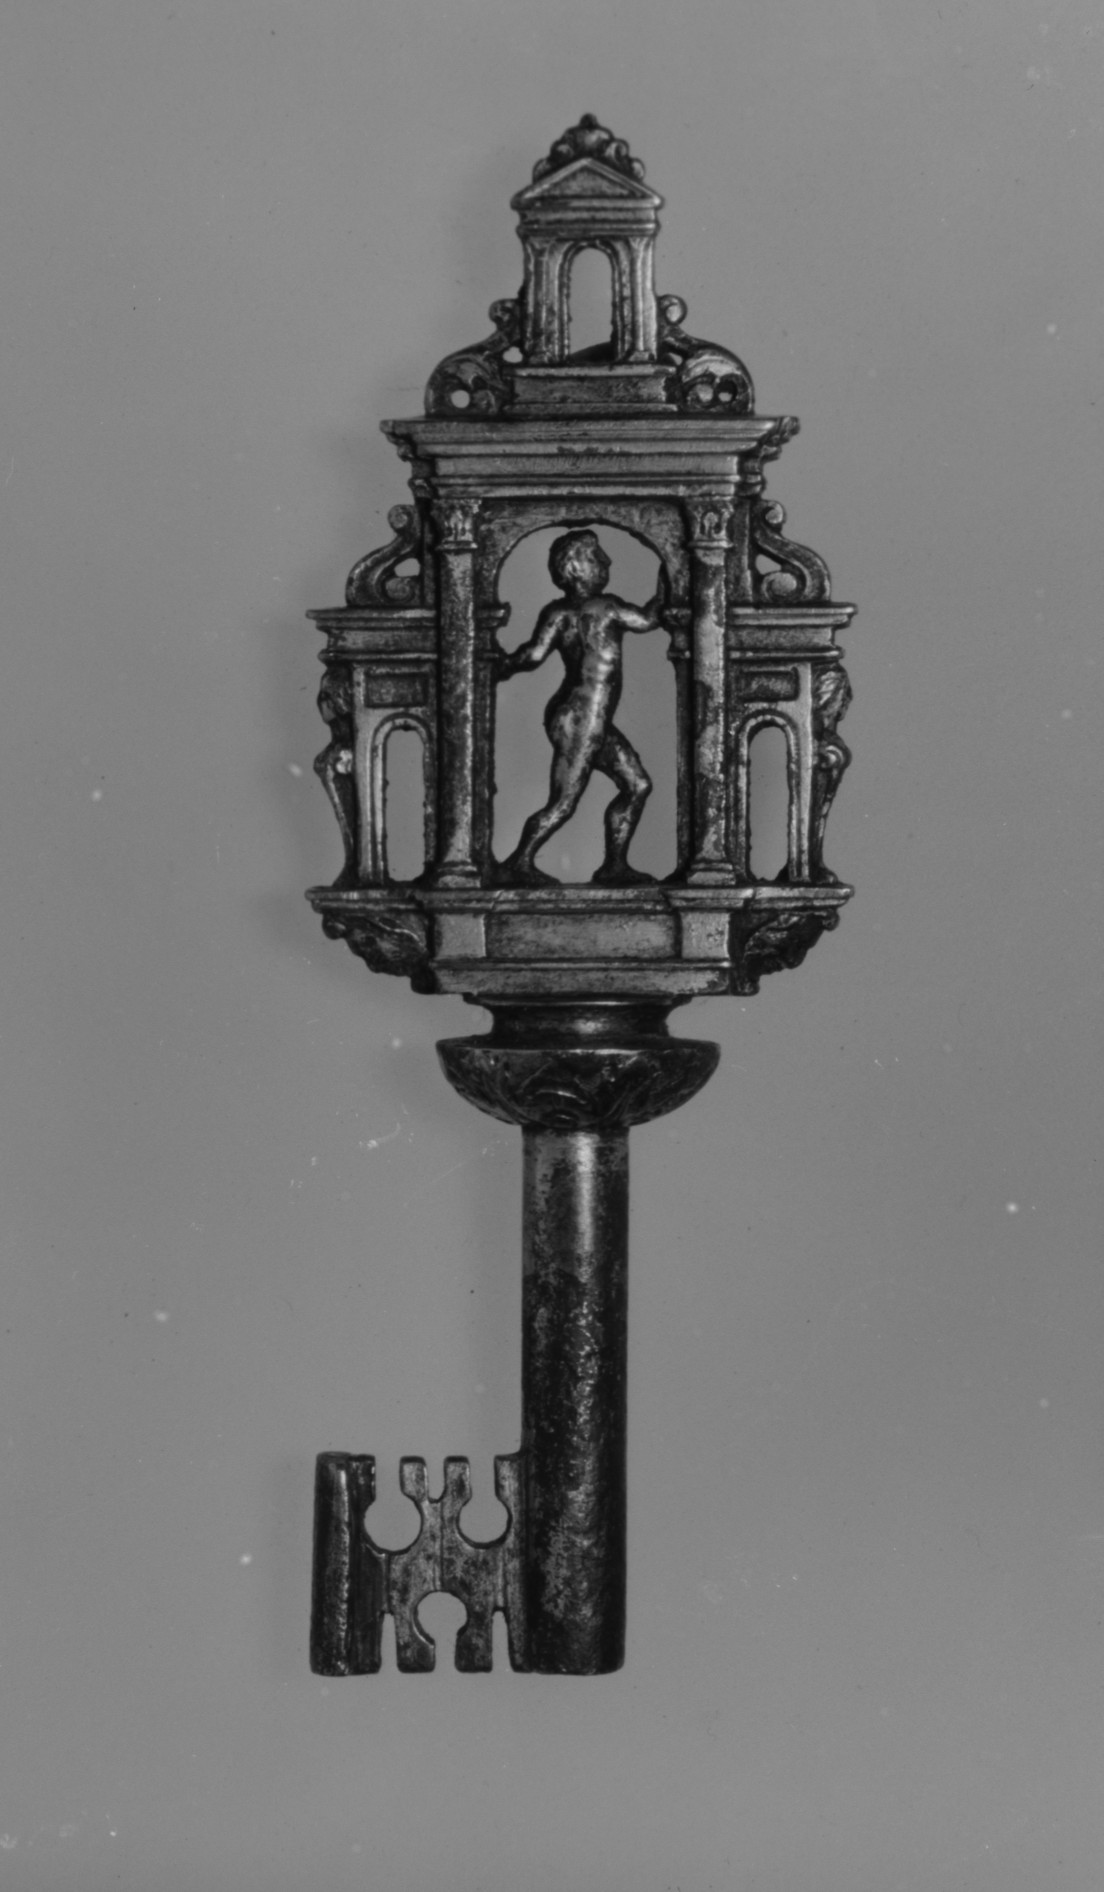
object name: key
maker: jacques androuet du cerceau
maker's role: designer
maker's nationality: french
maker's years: 1510-1585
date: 1550-1575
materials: gilt, iron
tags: male nudes